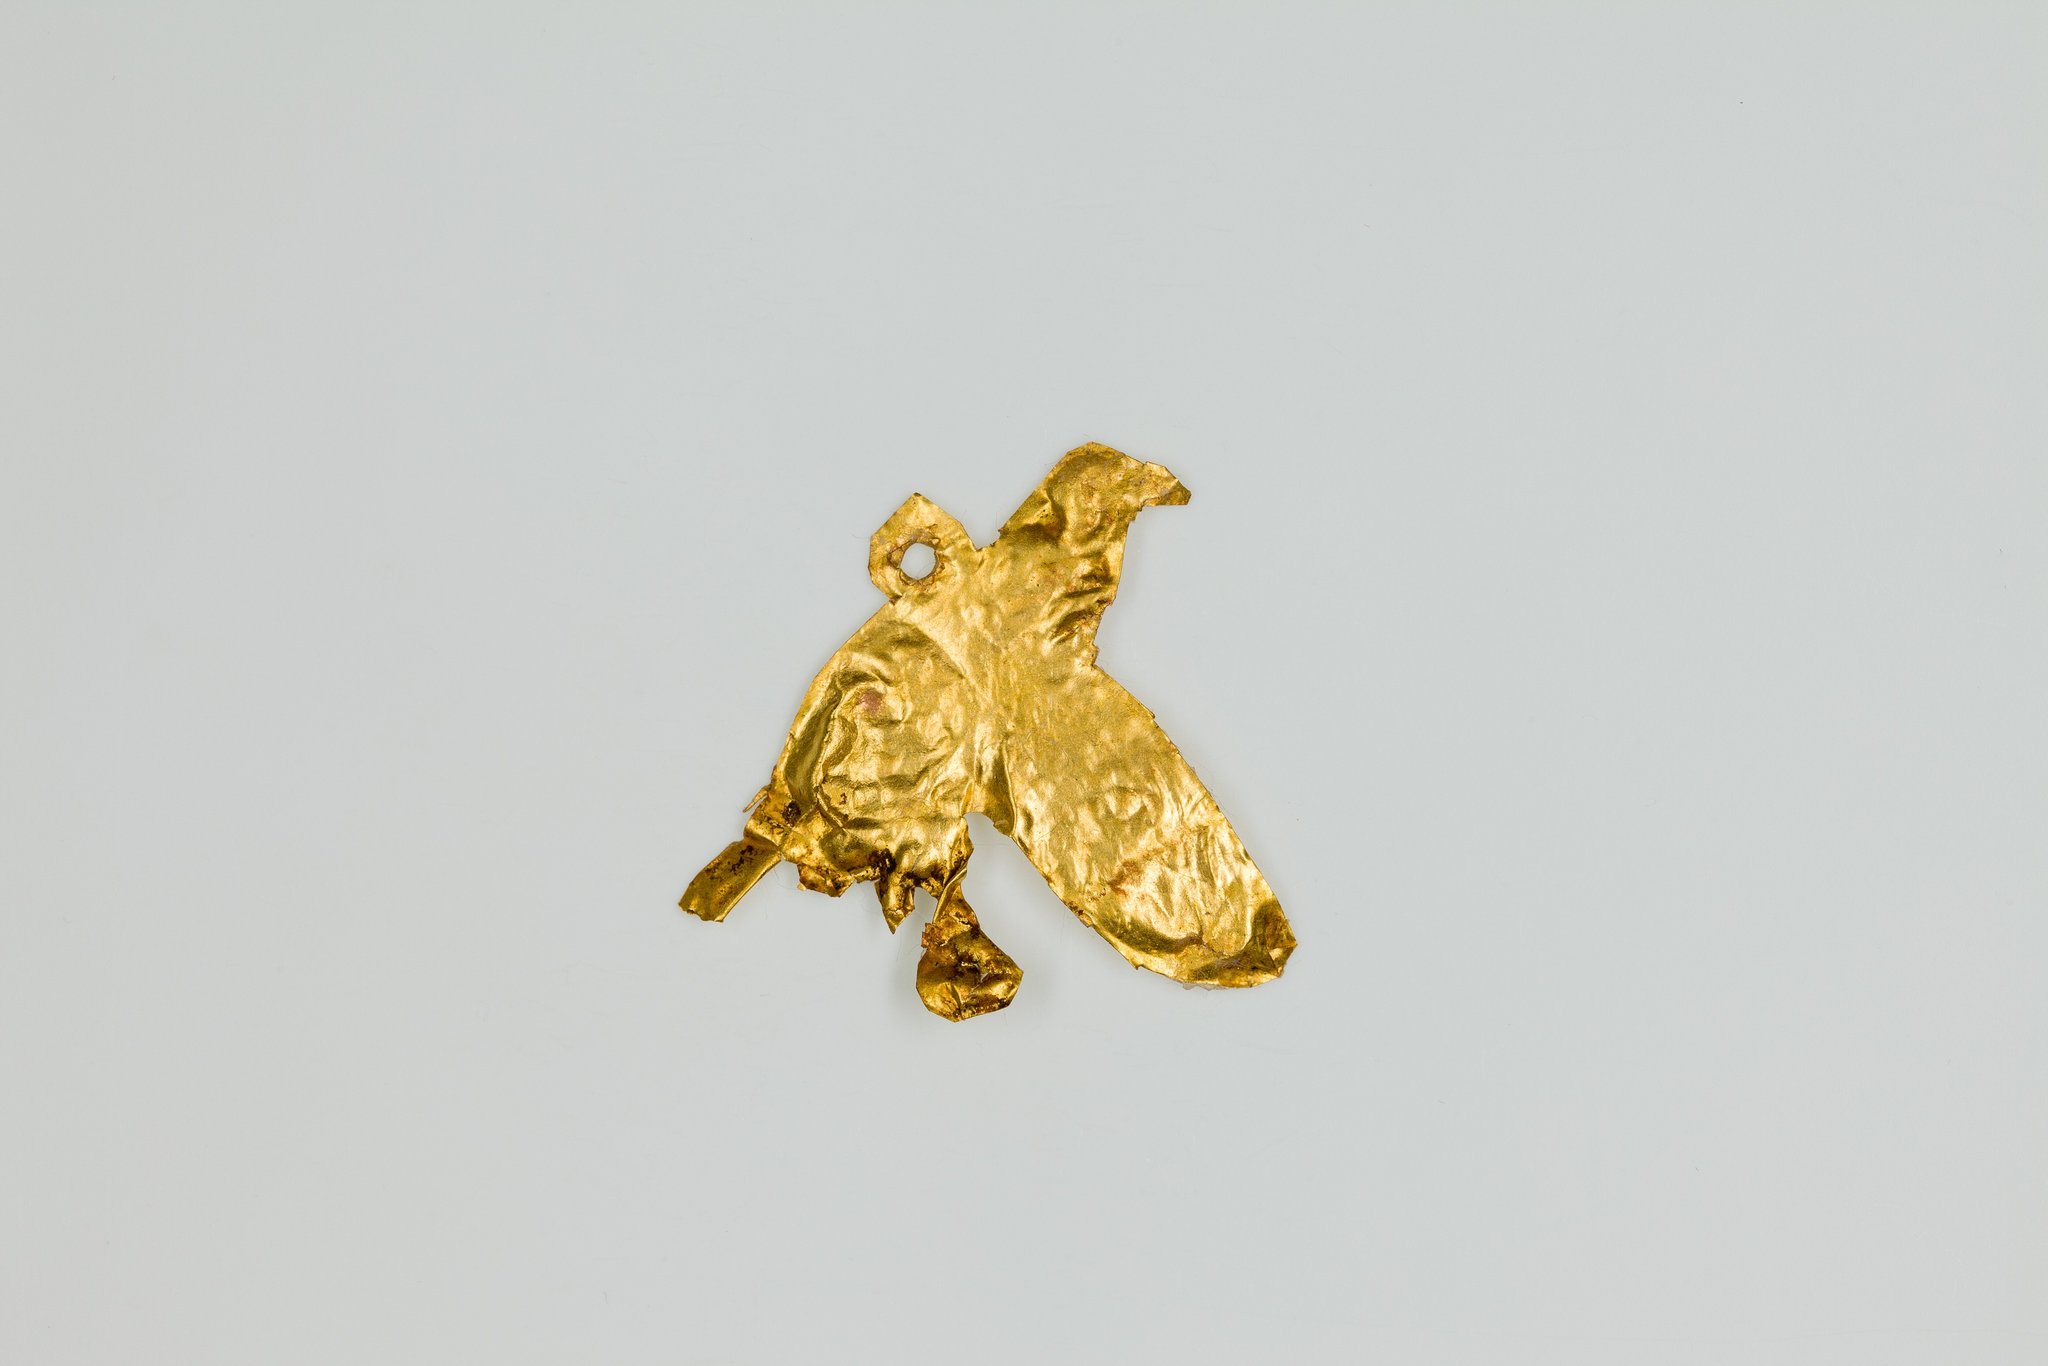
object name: amulet, vulture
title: Vulture amulet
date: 664-380 BCE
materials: gold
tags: birds